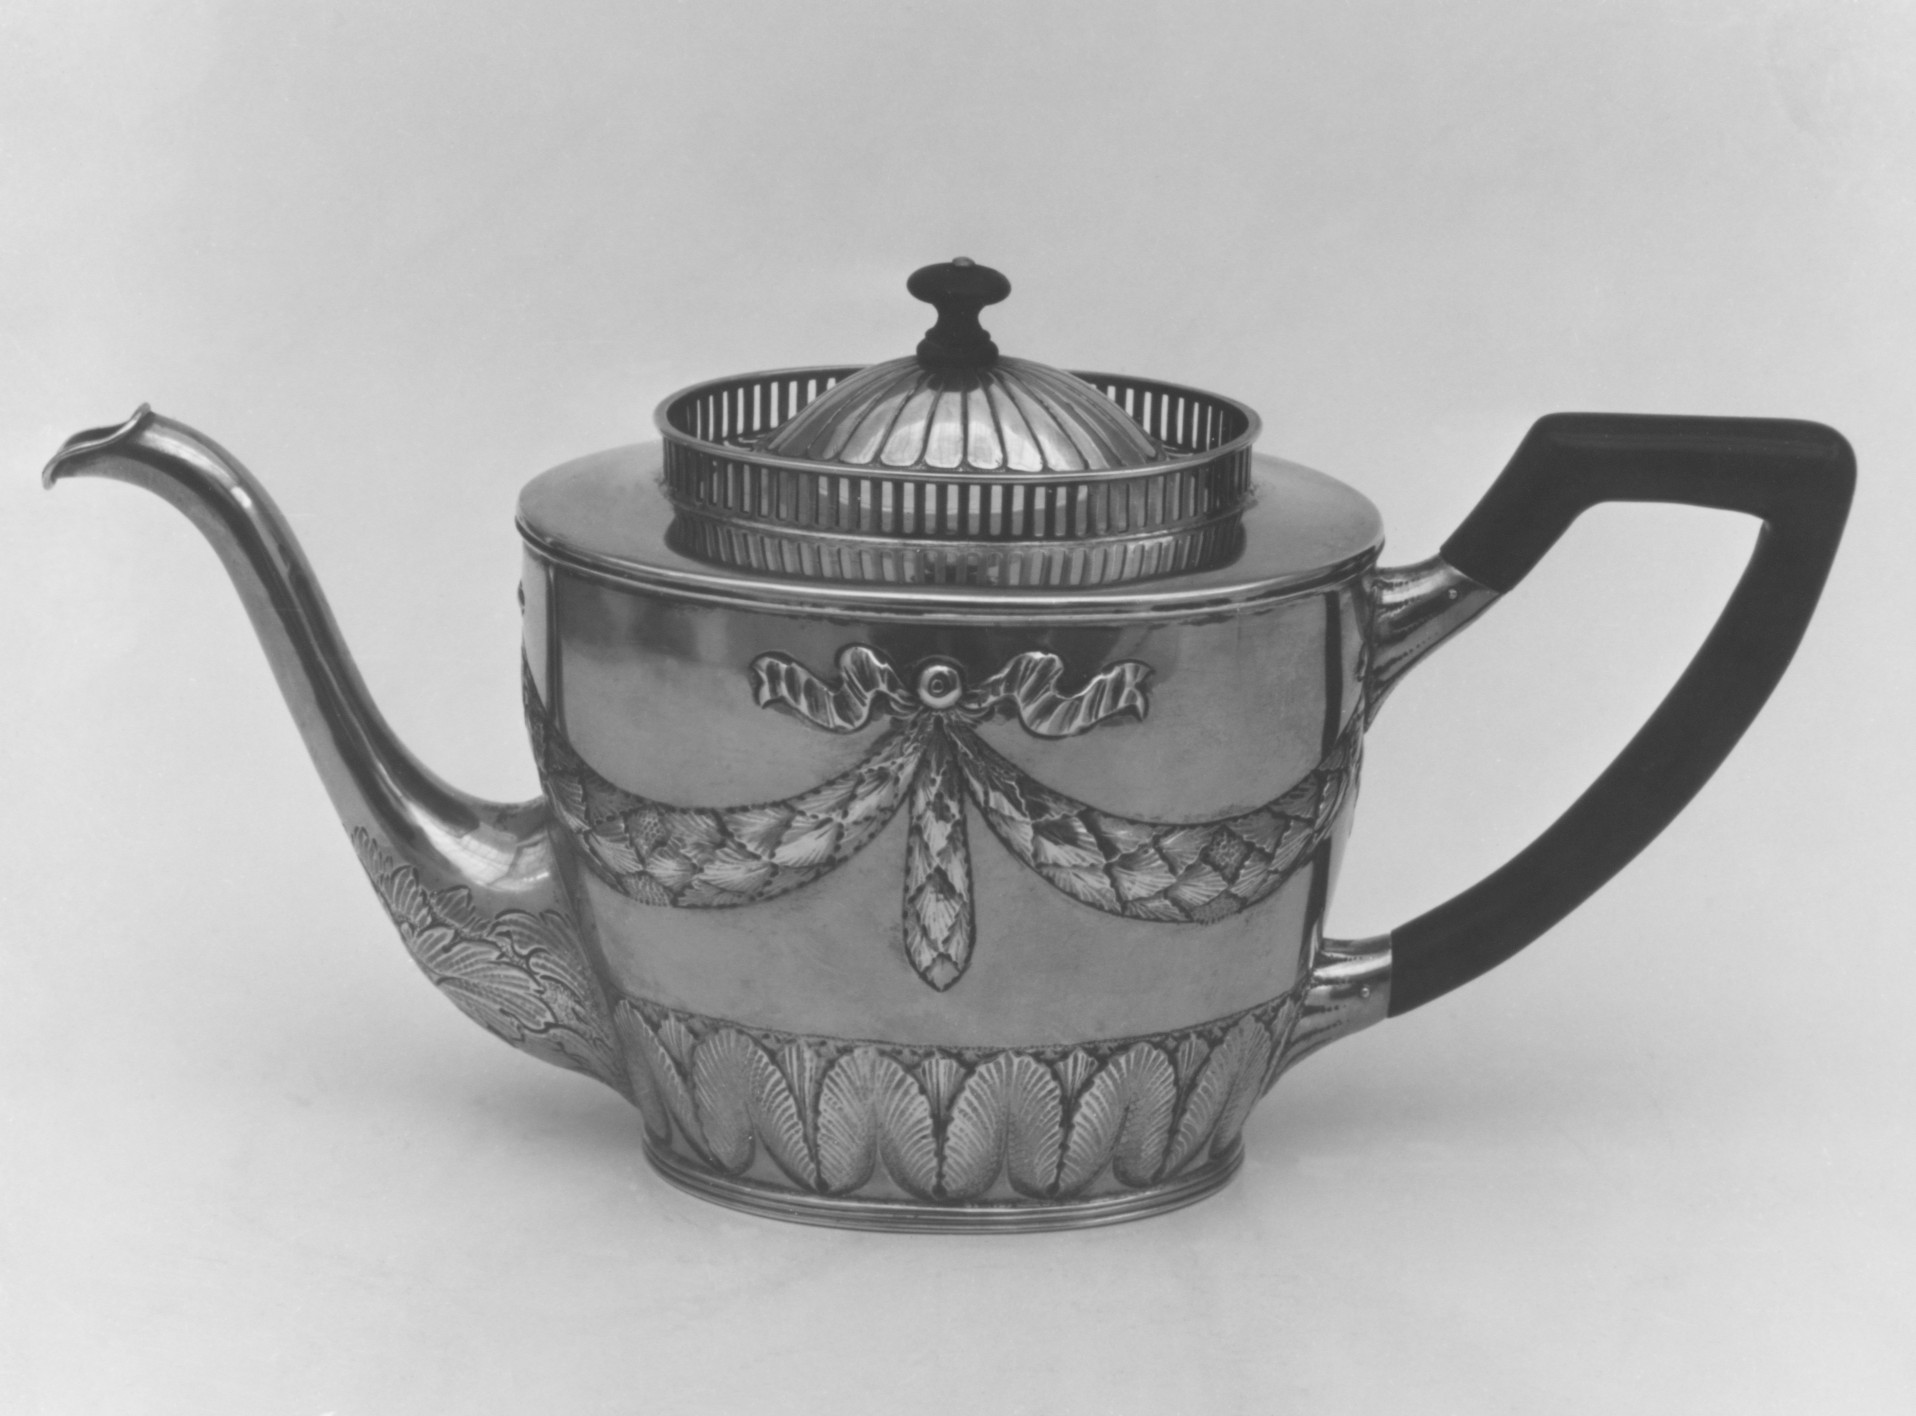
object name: teapot with cover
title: Teapot with cover (part of a set)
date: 1808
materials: silver gilt, wood